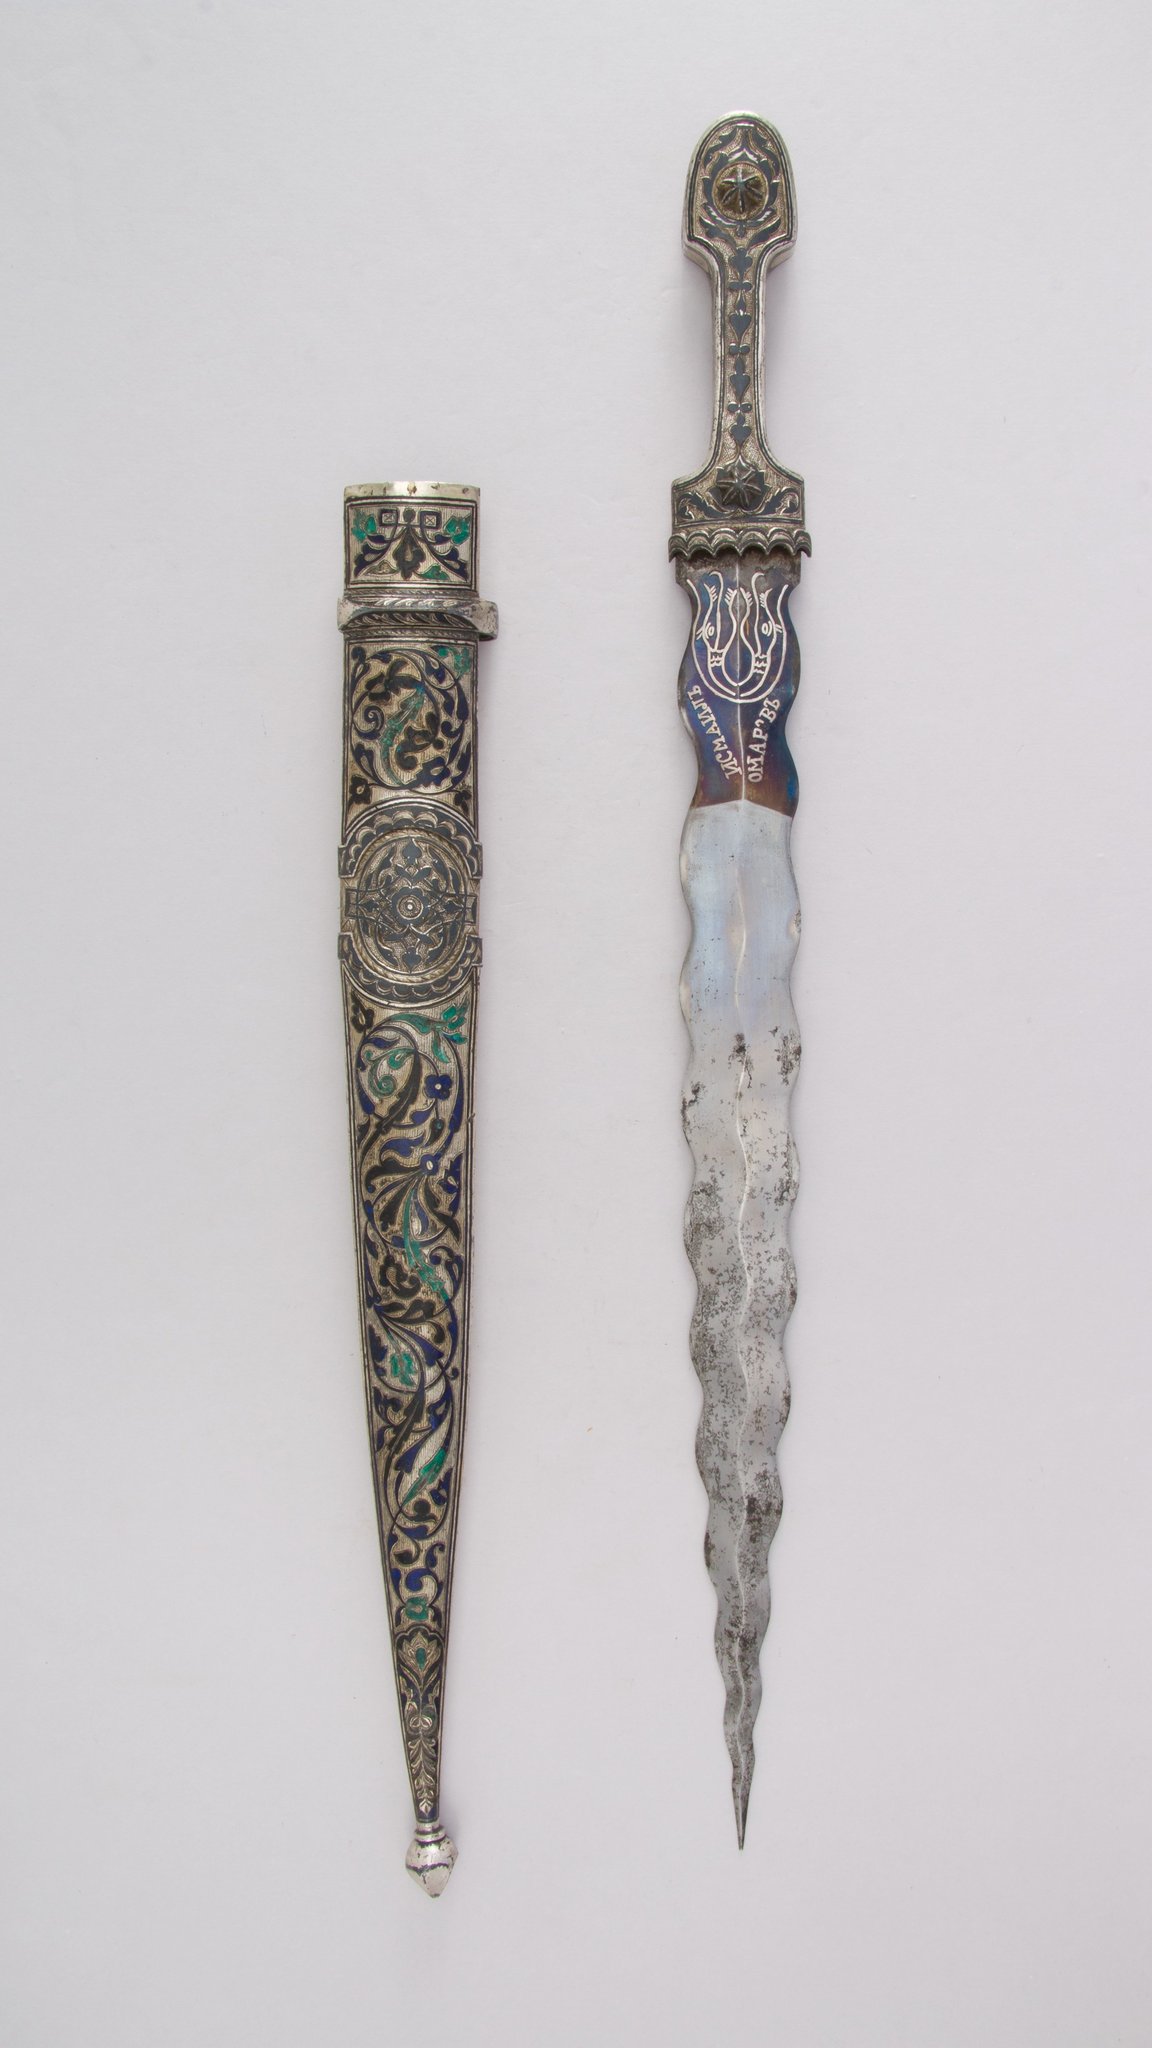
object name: dagger kindjal with sheath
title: Dagger (Kindjal) with Sheath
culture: caucasian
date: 1801-1900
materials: enamel, silver, steel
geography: caucasus